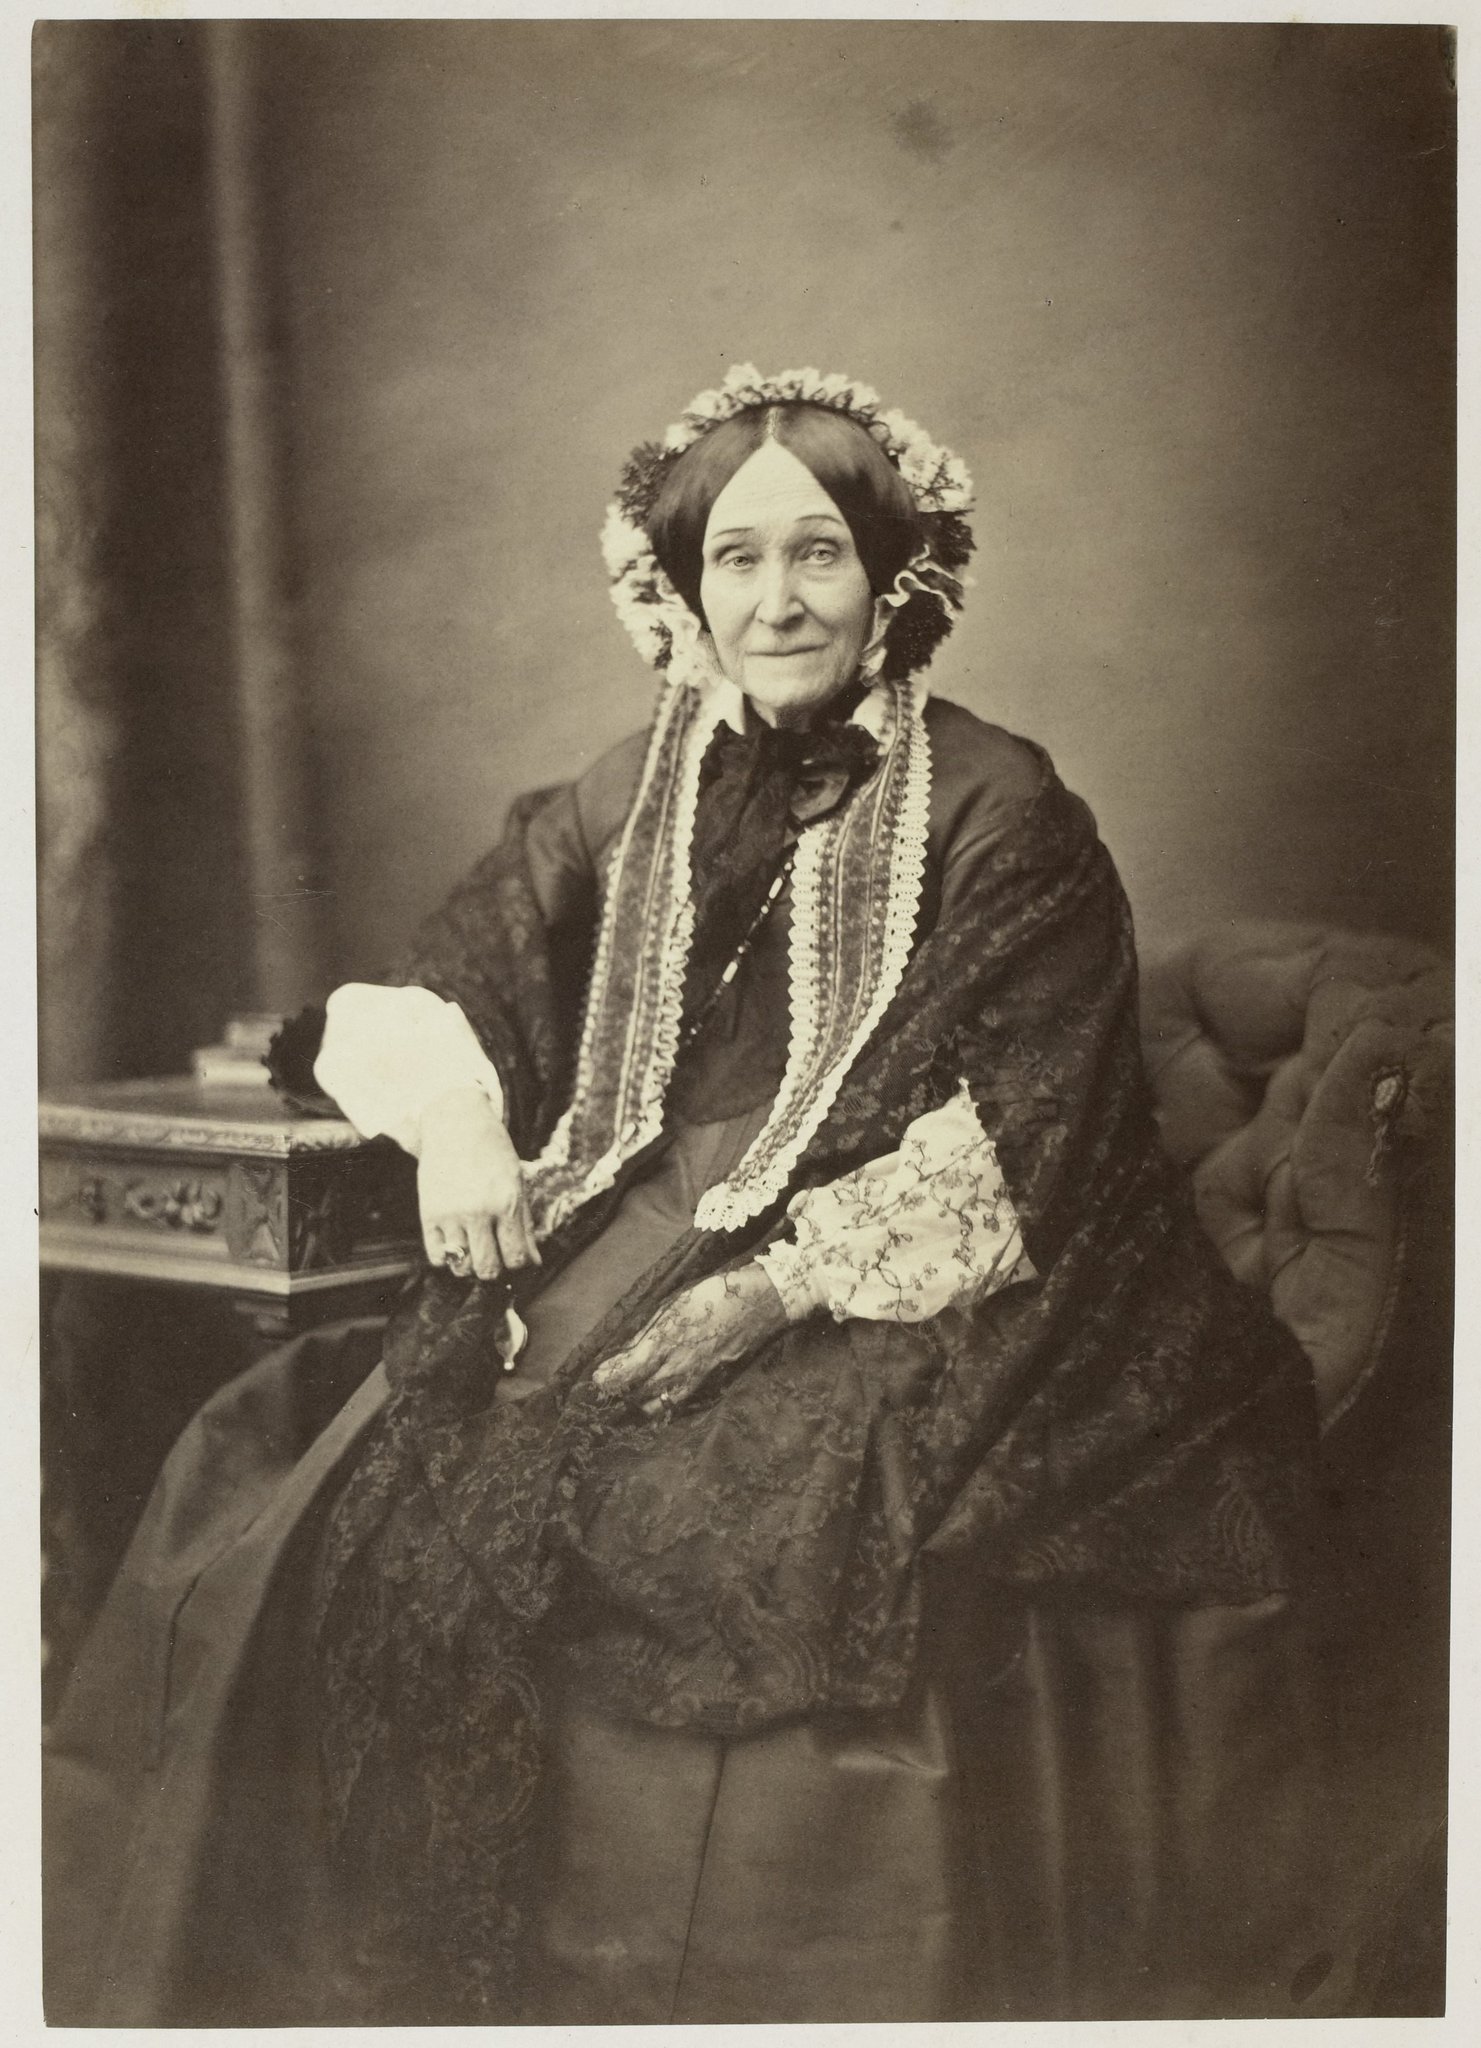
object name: photograph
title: Portret van een onbekende vrouw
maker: marie alexandre alophe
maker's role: print maker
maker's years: 1811-1883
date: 1855-1865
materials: cardboard, paper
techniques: albumen print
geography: paris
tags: adult woman, historical persons not known by name - bb - woman, paris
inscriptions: check stamp, inscription: ‘M. Alophe peintre & photographe/ 35, Boulevart des Capucines.’